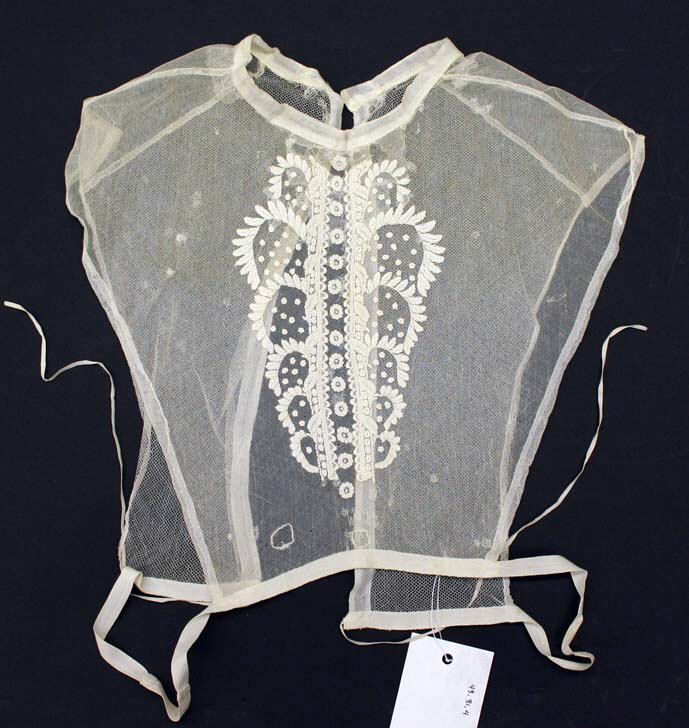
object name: vestee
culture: american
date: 1860-1869